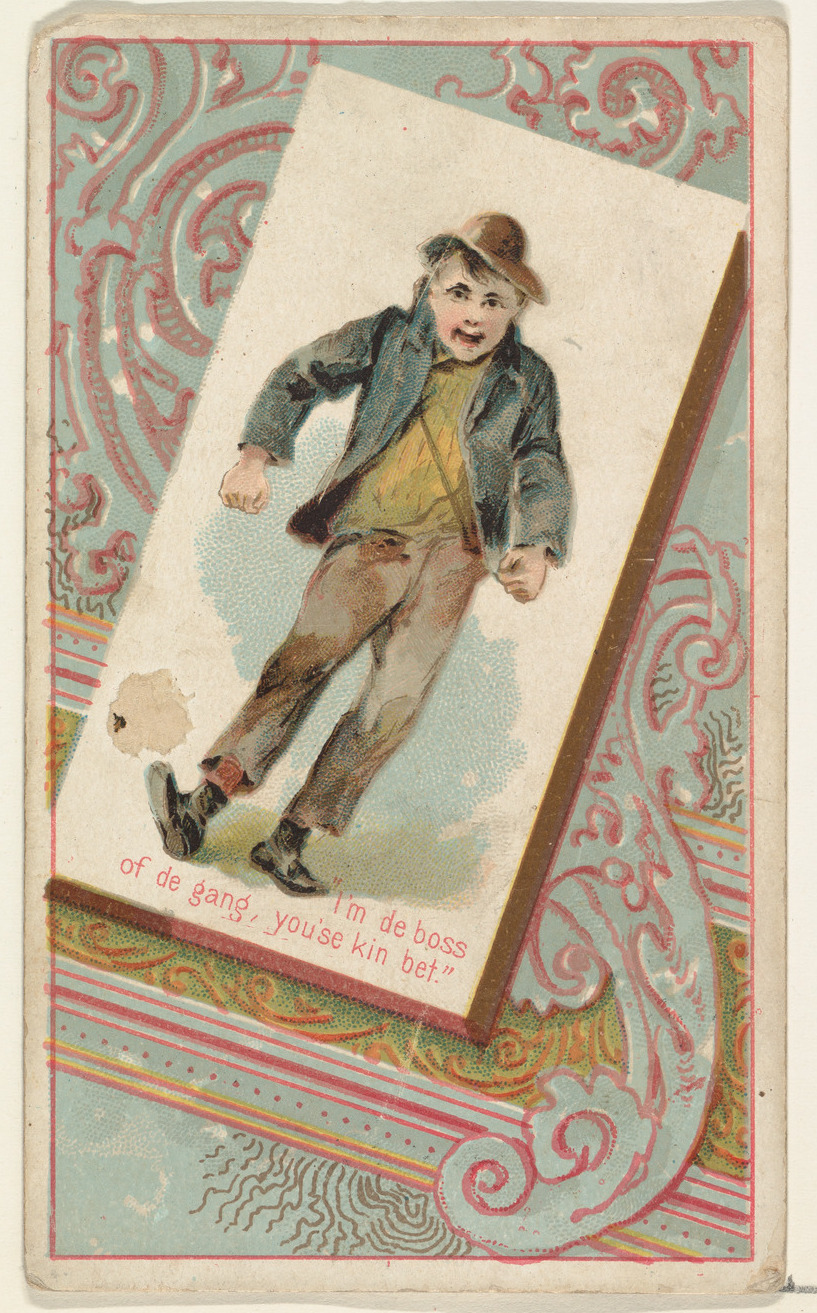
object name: print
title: "I'm de boss of de gang, you'se kin bet," from the Terrors of America set (N136) issued by Duke Sons & Co. to promote Honest Long Cut Tobacco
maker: w. duke, sons & co.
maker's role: publisher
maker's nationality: american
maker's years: 1870-1920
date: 1888-1889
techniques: color lithograph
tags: men